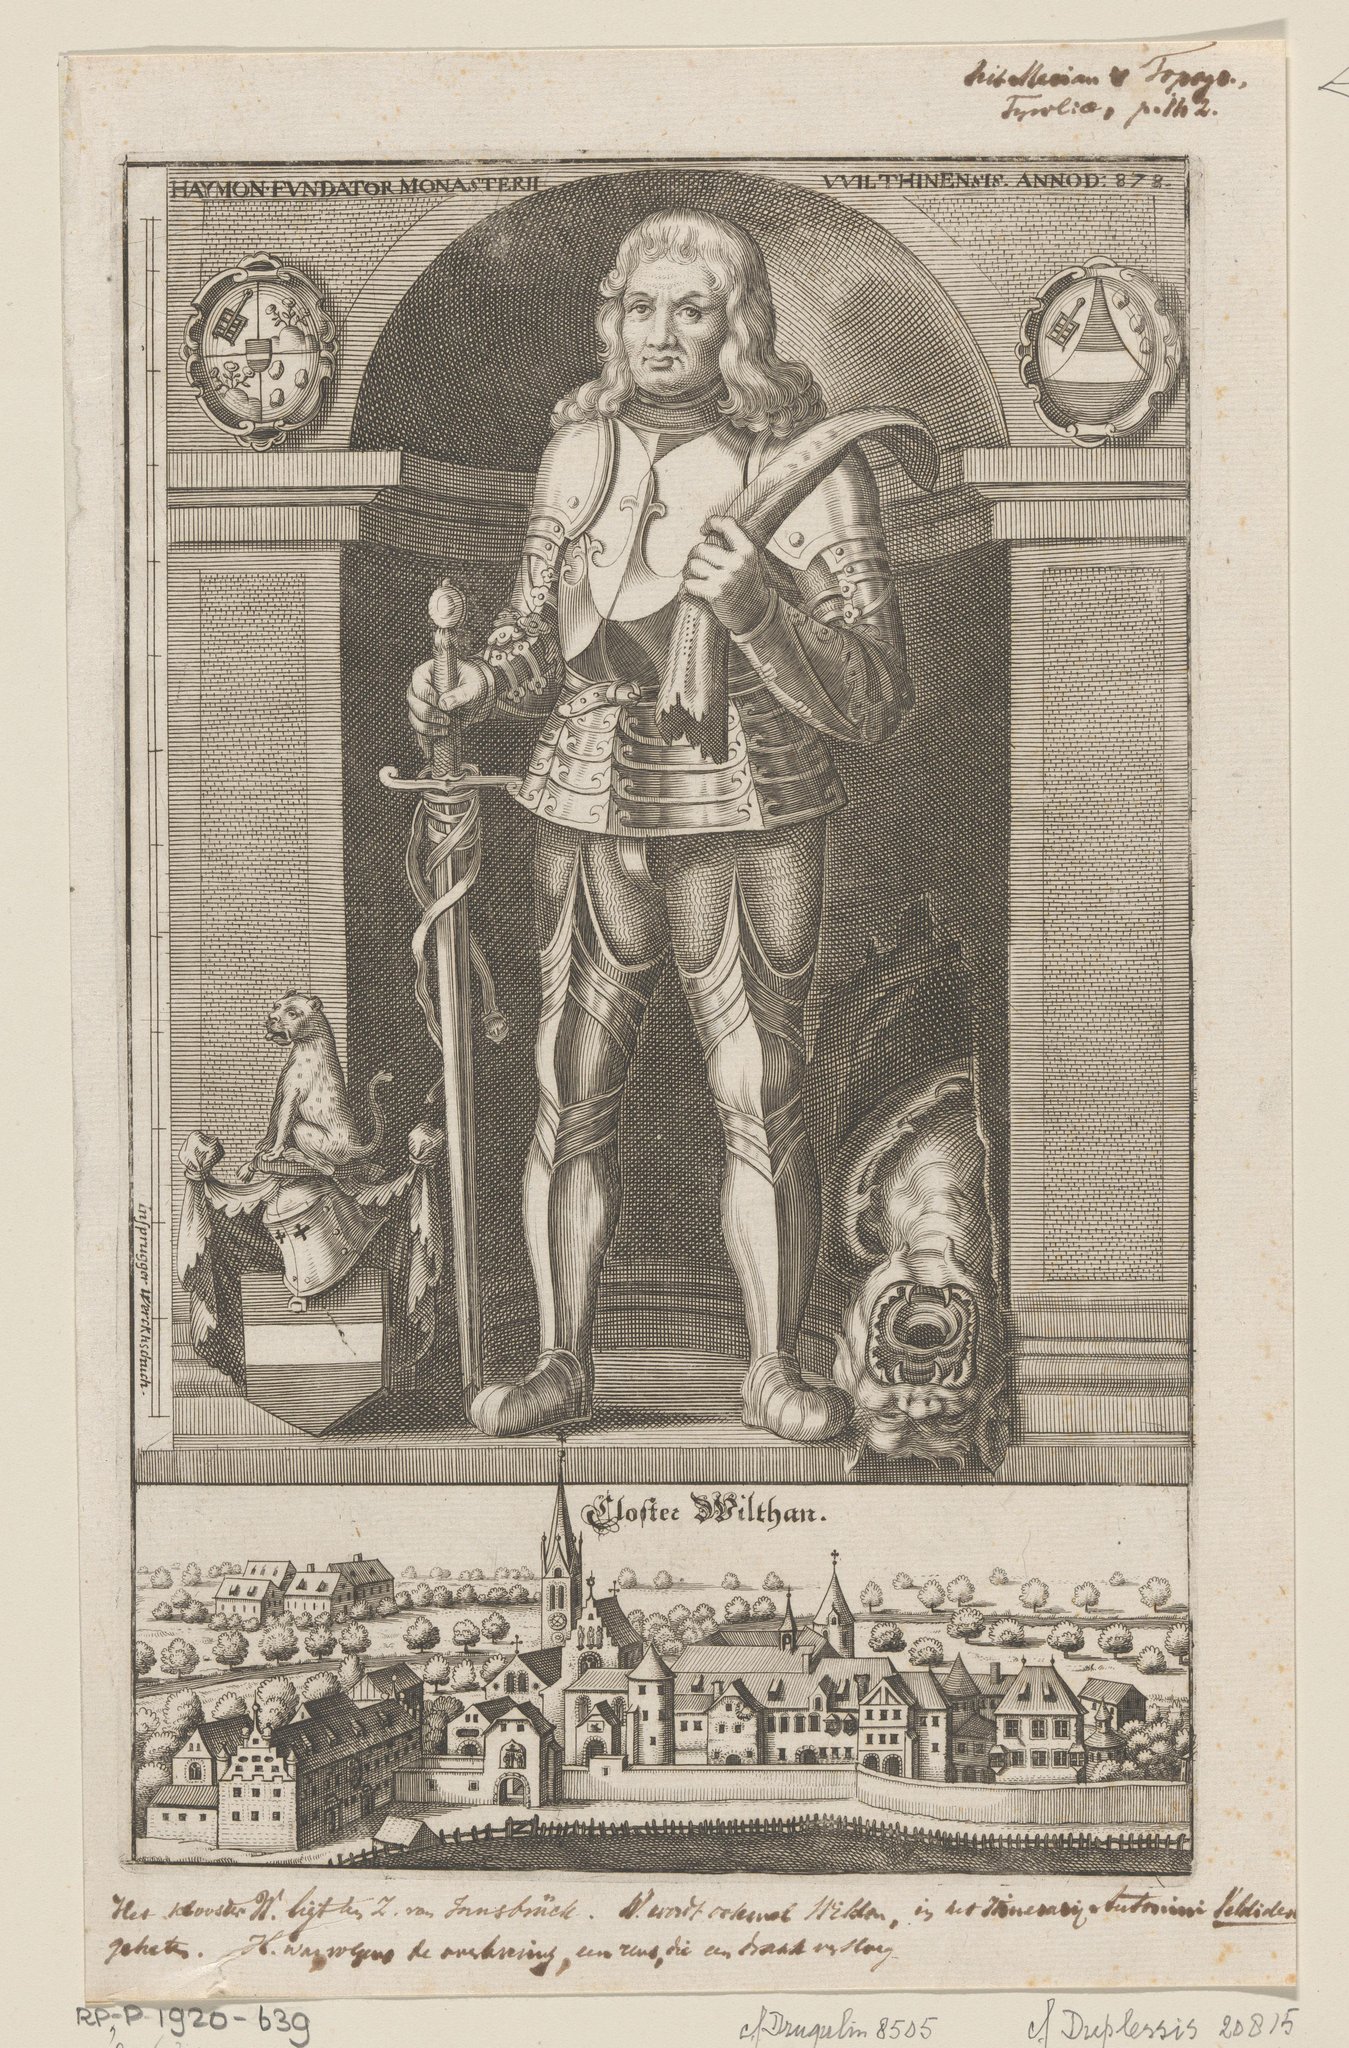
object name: print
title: Portret van Haymon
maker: Anonymous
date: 1679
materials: paper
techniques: engraving, etching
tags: cloisters ~ monastery, giants, colossi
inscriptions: inscription: ‘Het klooster W. (...) een draak versloeg.’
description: Prent waarschijnlijk uit: Zeiller, Martin. Topographia provinciarum austriacarum Austriae, Styriae, Carinthiae, Carniolae, Tyrolis, etc. (...). Frankfurt am Main: Matthäus Merian, 1679.